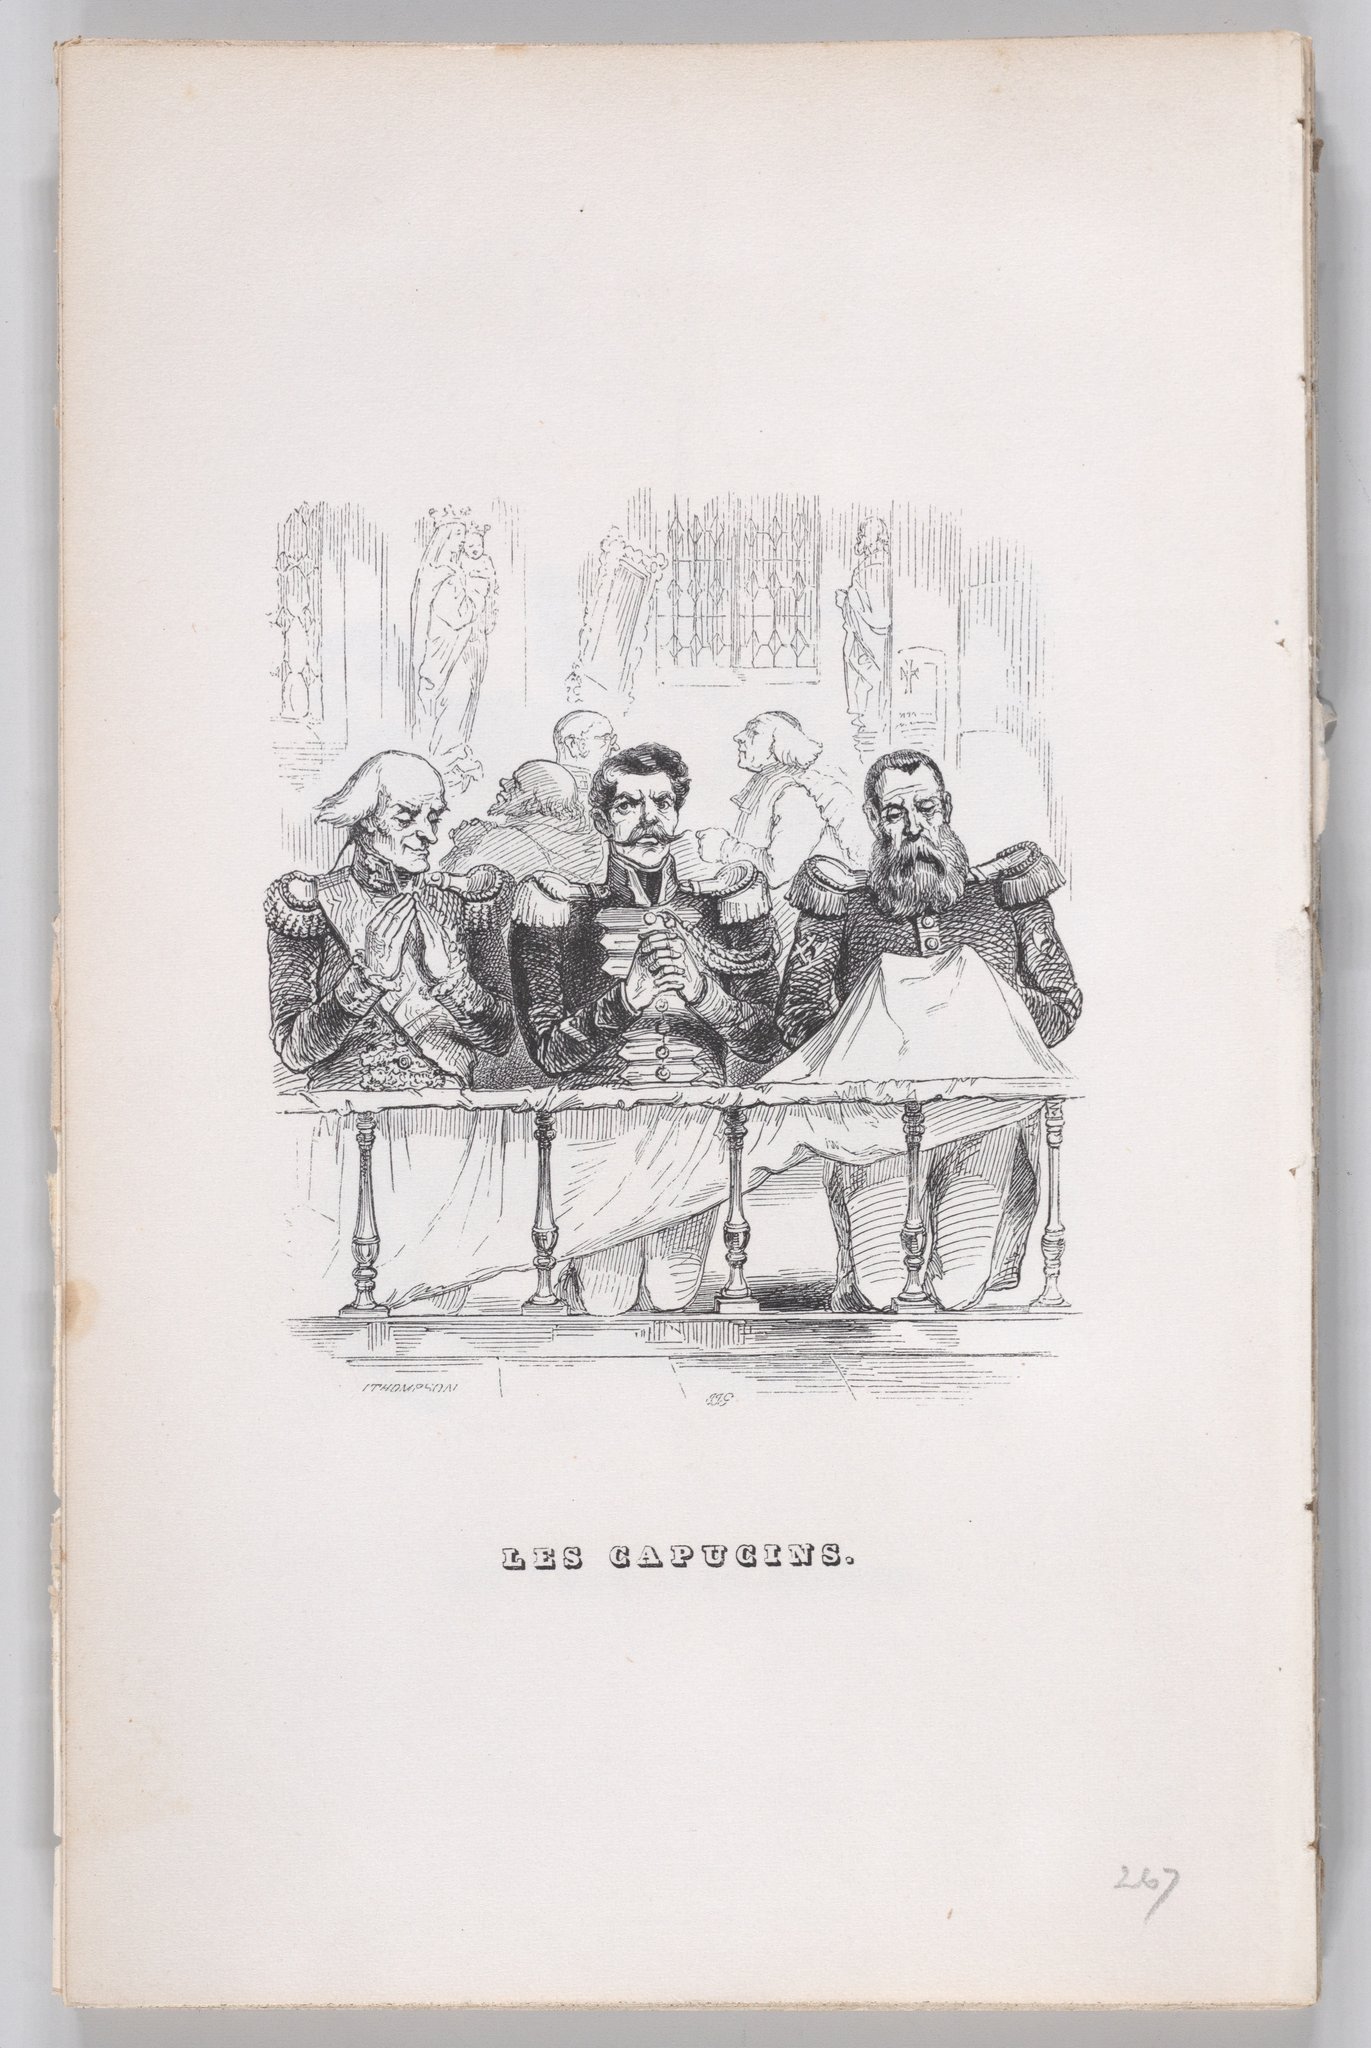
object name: print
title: The Capuchins, from "The Complete Works of Béranger"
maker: j. j. grandville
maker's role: illustrator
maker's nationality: french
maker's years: 1803-1847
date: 1836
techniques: engraving